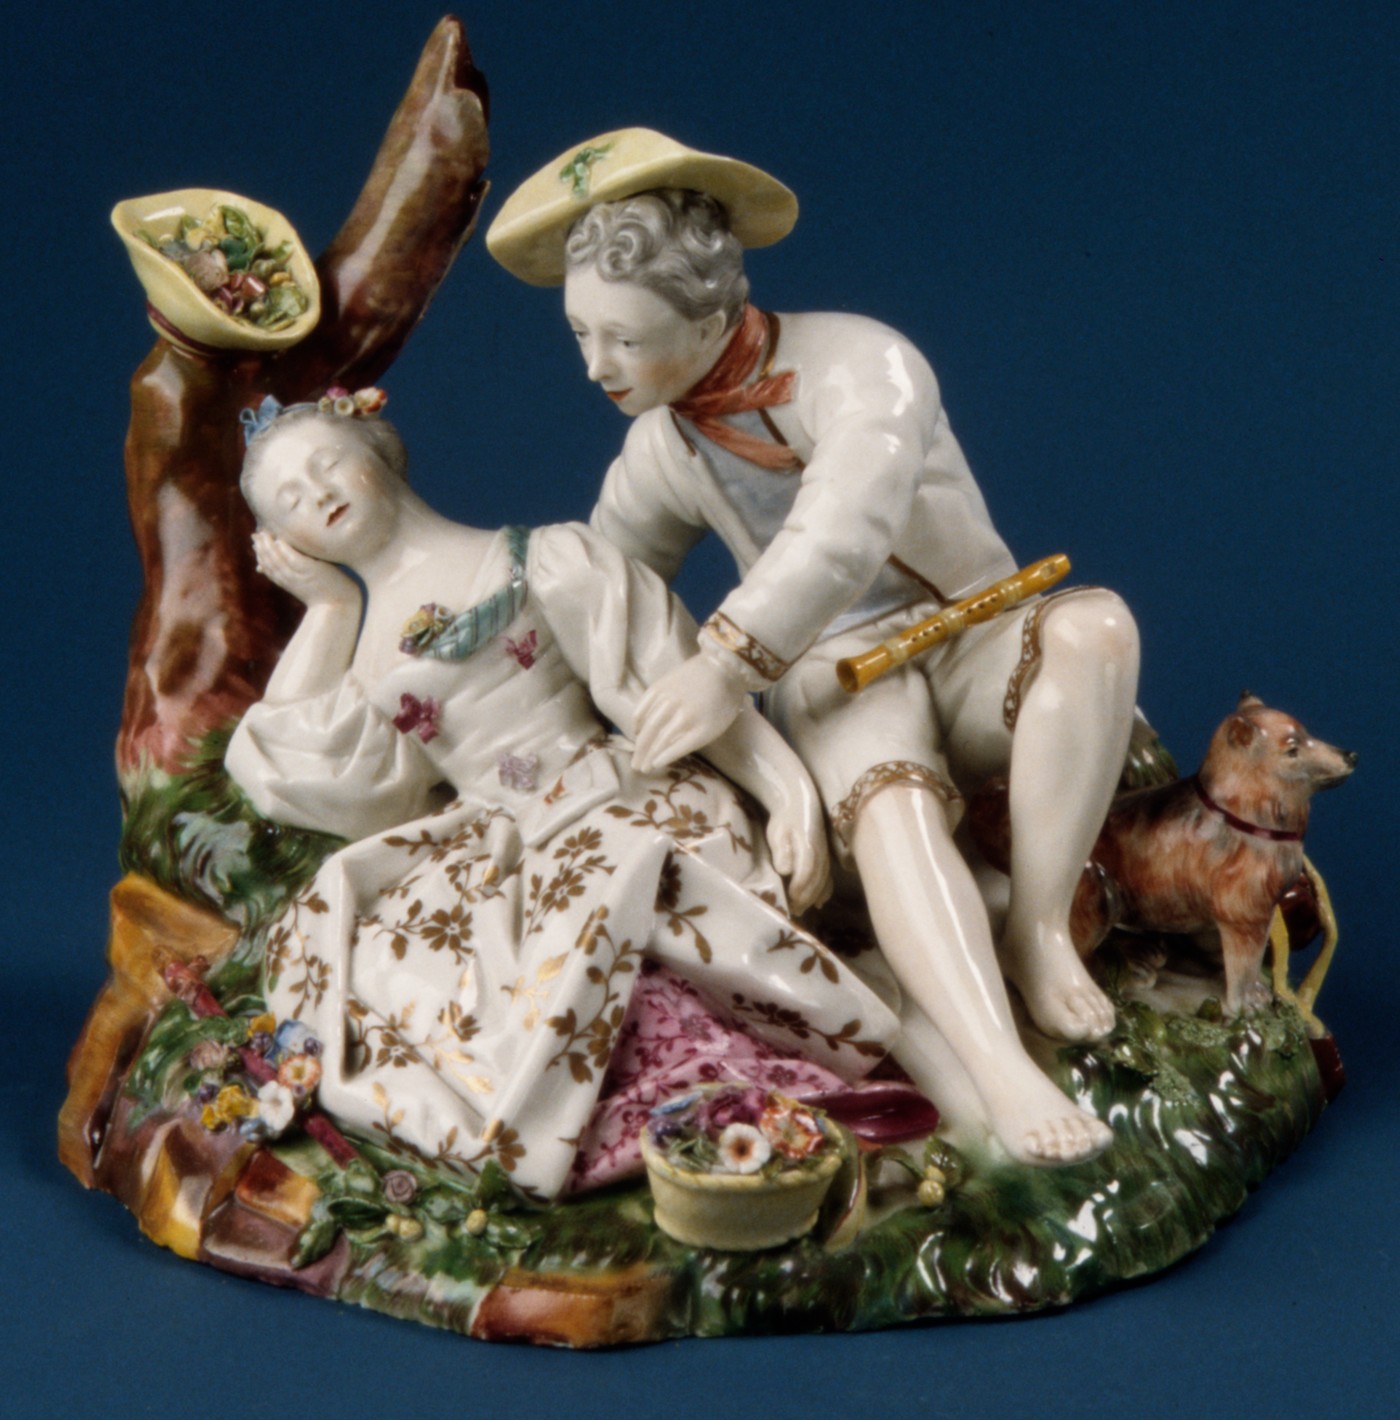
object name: group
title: The Sleeping Shepherdess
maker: fulda pottery and porcelain manufactory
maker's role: manufactory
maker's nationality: german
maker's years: 1764-1789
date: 1775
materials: hard paste porcelain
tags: sleeping,men,women,dogs,shepherds